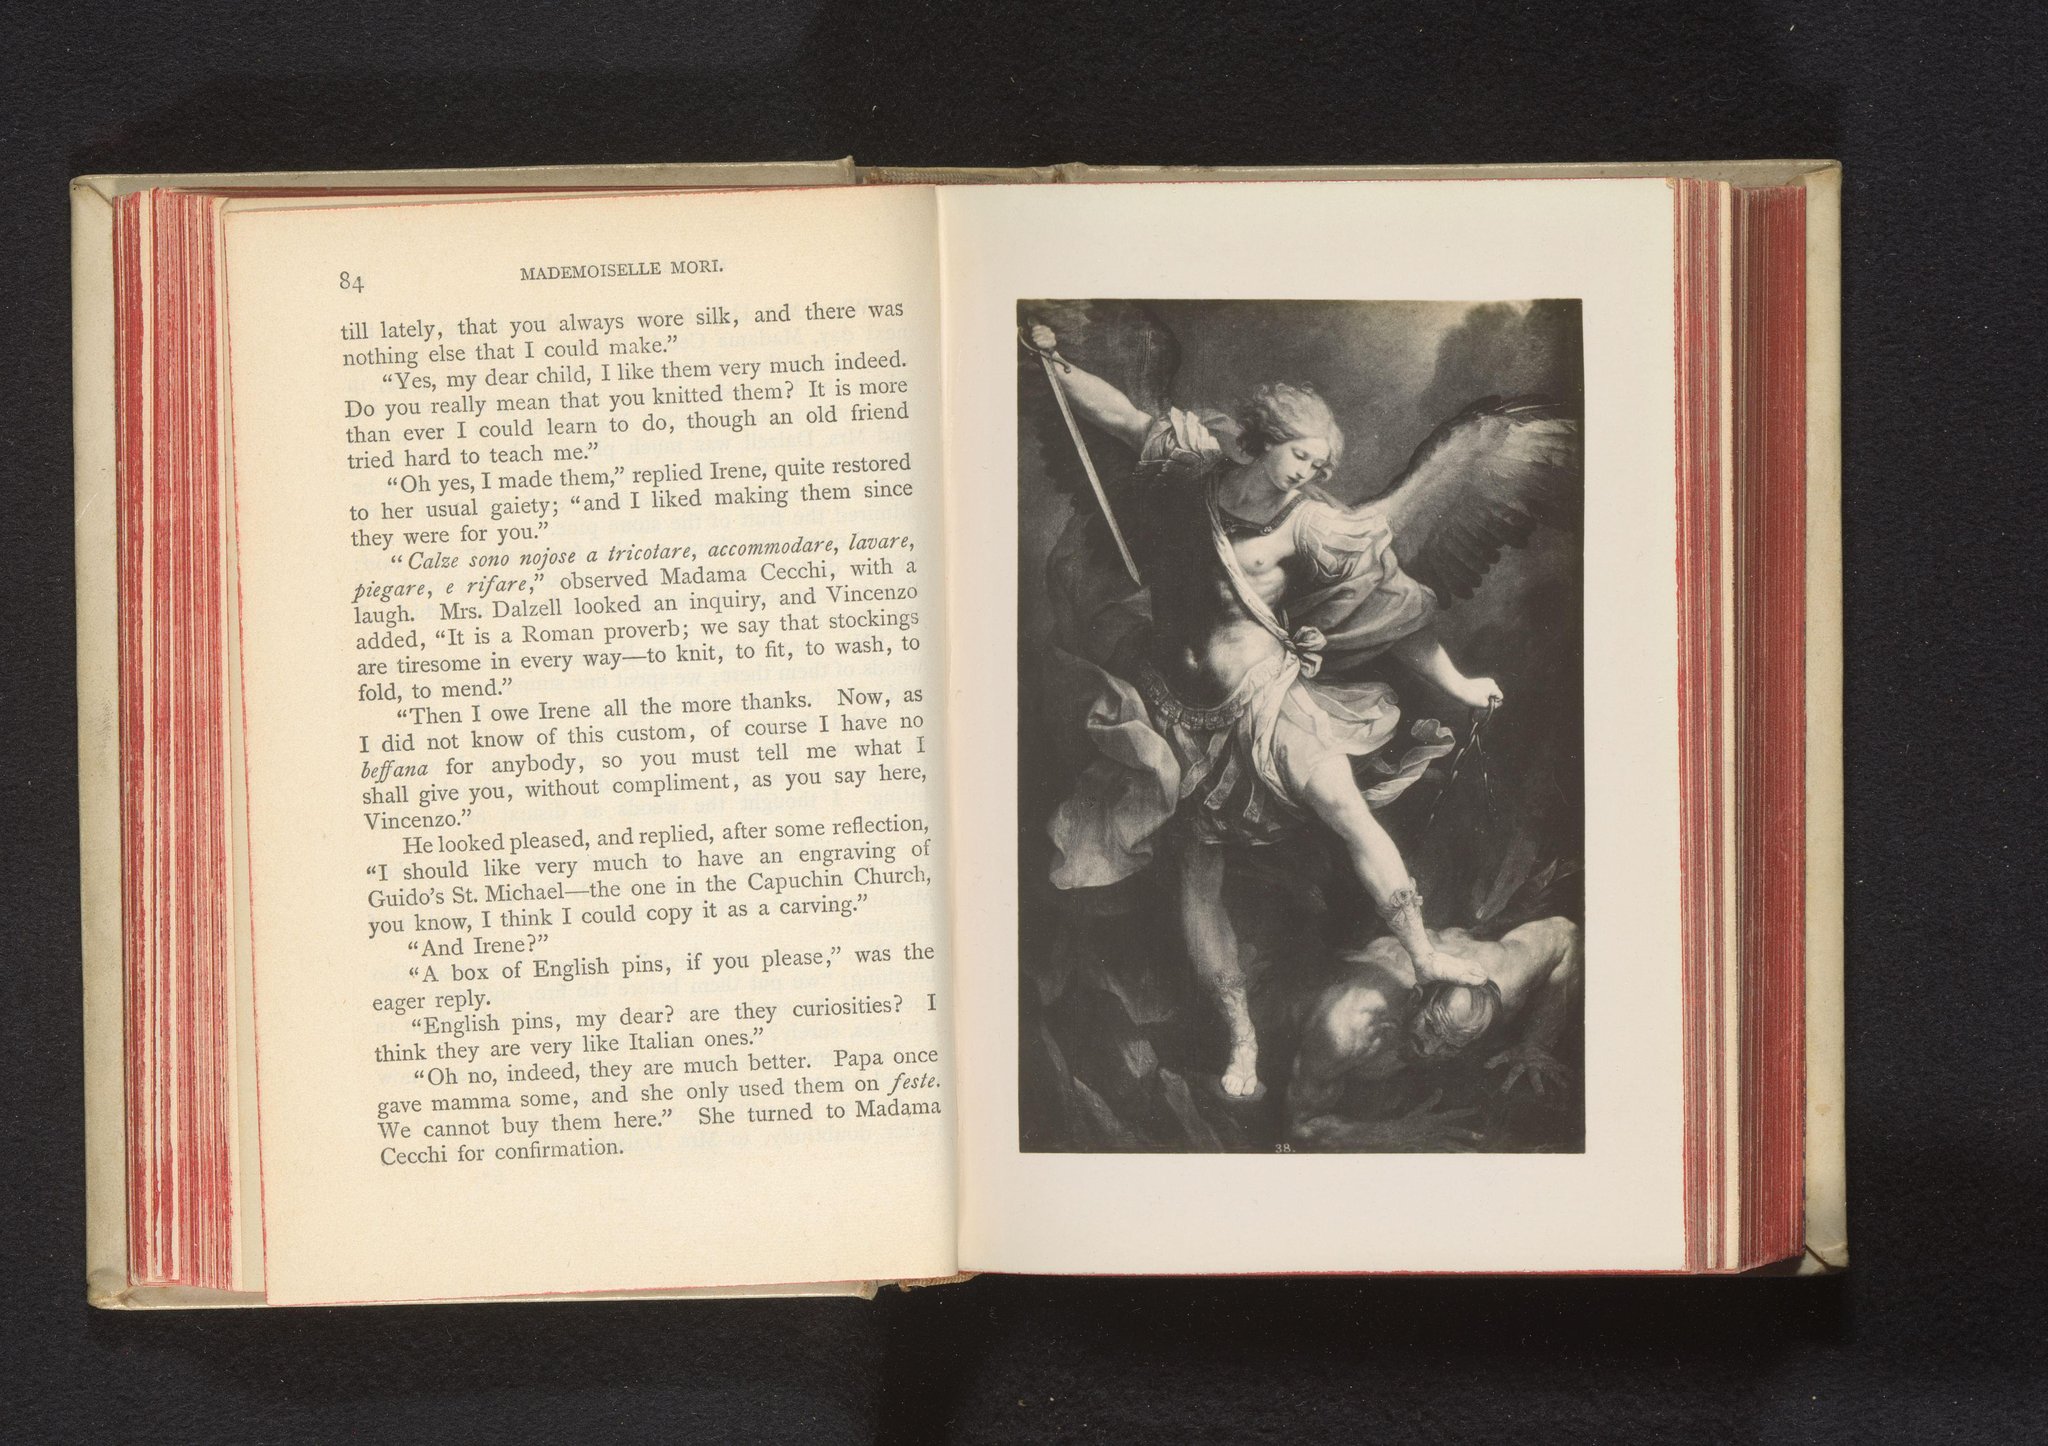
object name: reproduction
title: Fotoreproductie van een schilderij, voorstellende de aartsengel Michaël vertrapt Satan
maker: Anonymous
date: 1852-1862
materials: photographic support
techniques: gelatin silver print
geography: santa maria della concezione dei cappuccini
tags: the archangel michael fighting the dragon (devil, satan)